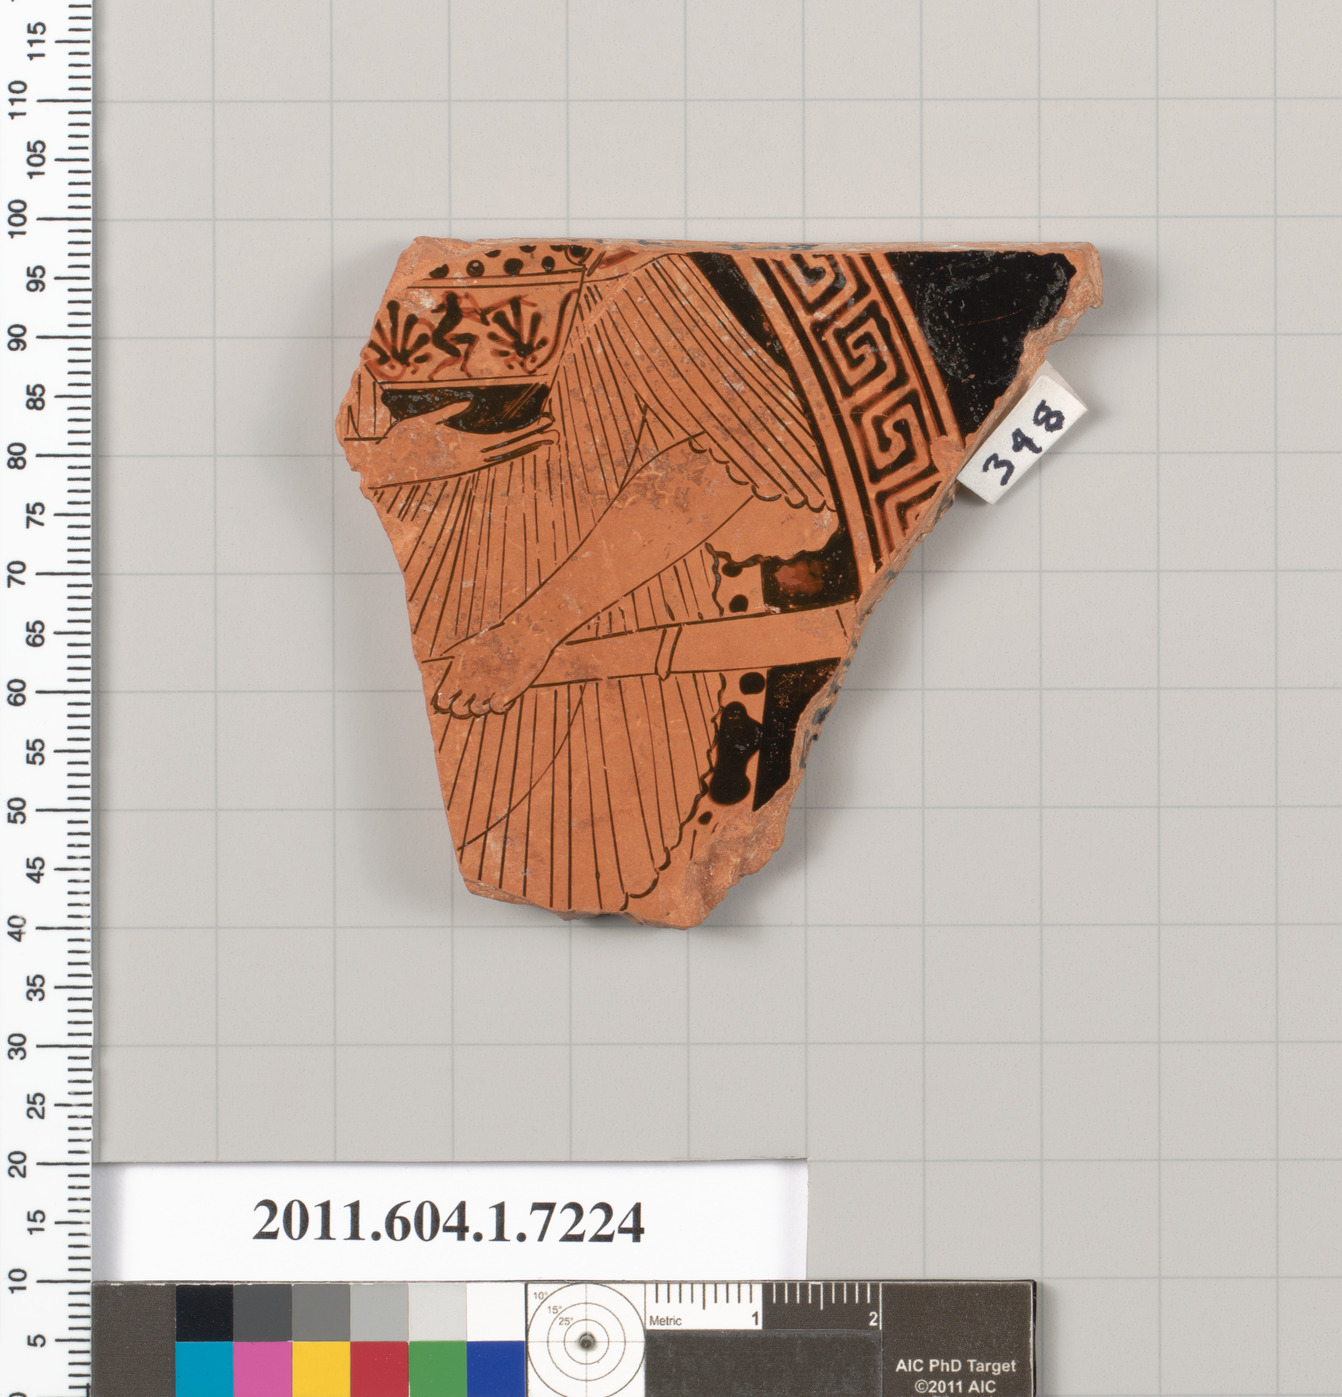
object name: kylix fragment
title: Terracotta fragment of a kylix (drinking cup)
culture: greek, attic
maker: makron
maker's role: artist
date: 500-480 BCE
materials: terracotta